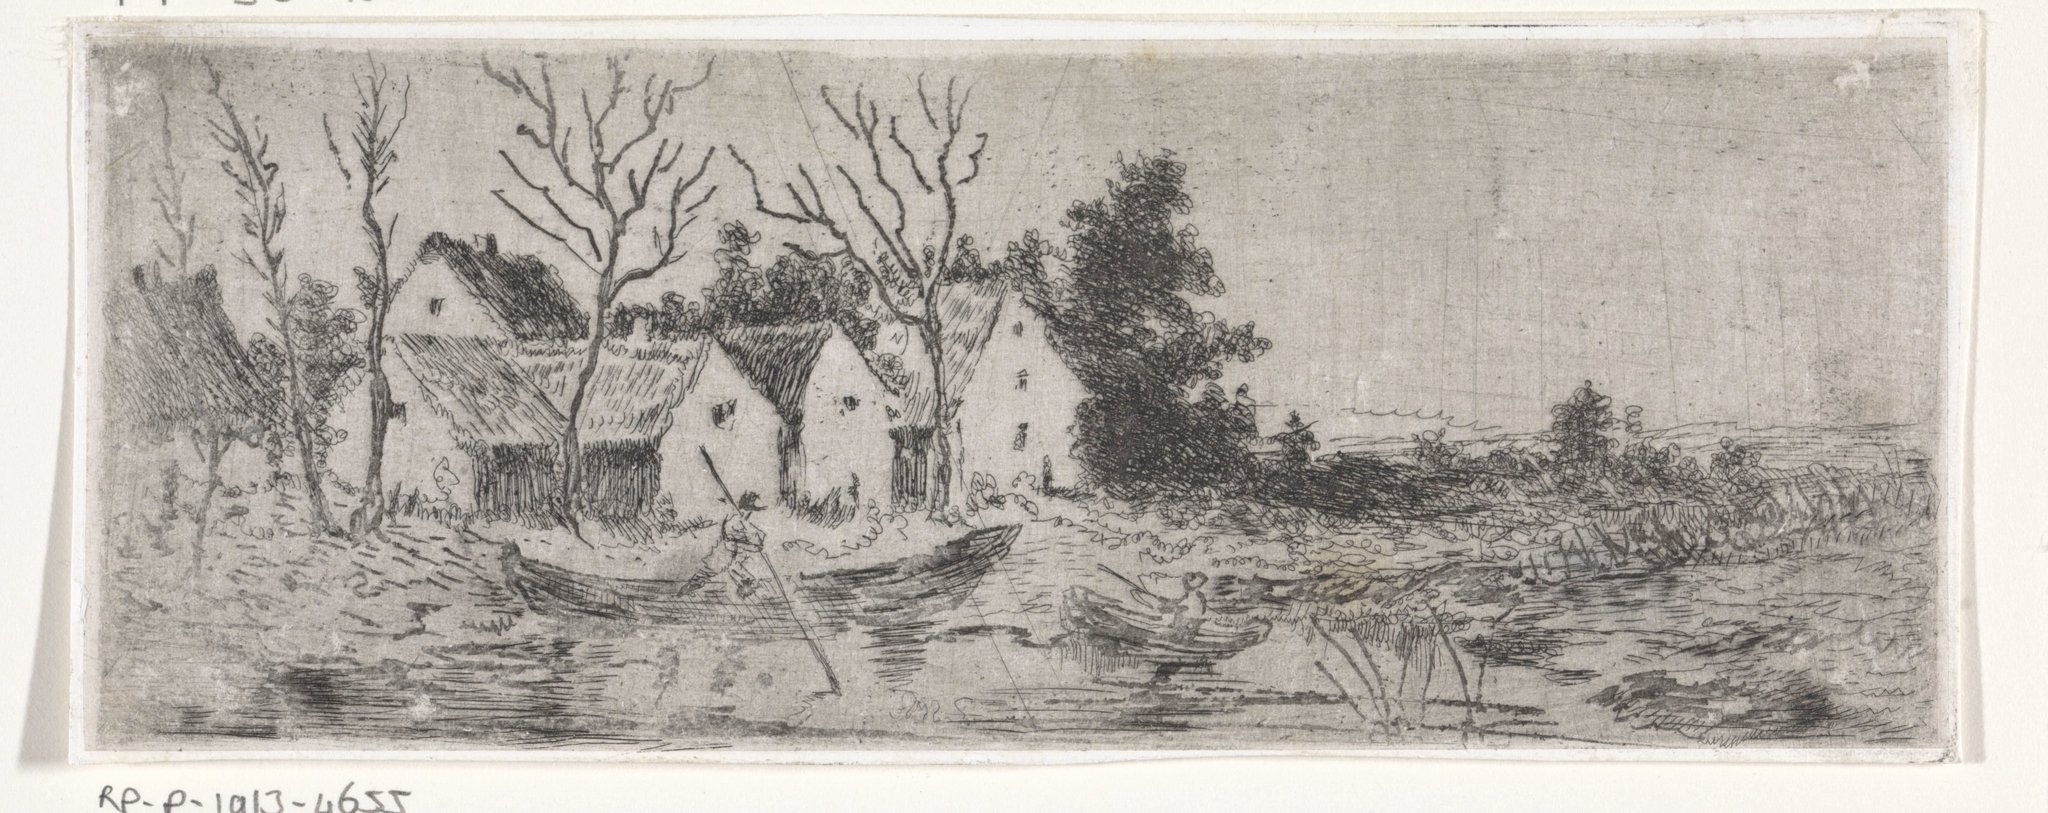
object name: print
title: Waterrijk landschap met huizen en kale bomen aan de oever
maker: arnoud schaepkens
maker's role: print maker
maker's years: 1816-1904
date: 1855-1904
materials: paper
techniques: drypoint, etching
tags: trees, landscapes with waters, waterscapes, seascapes (in the temperate zone), rowing-boat, canoe, etc.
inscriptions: collector's mark: Lugt 2228